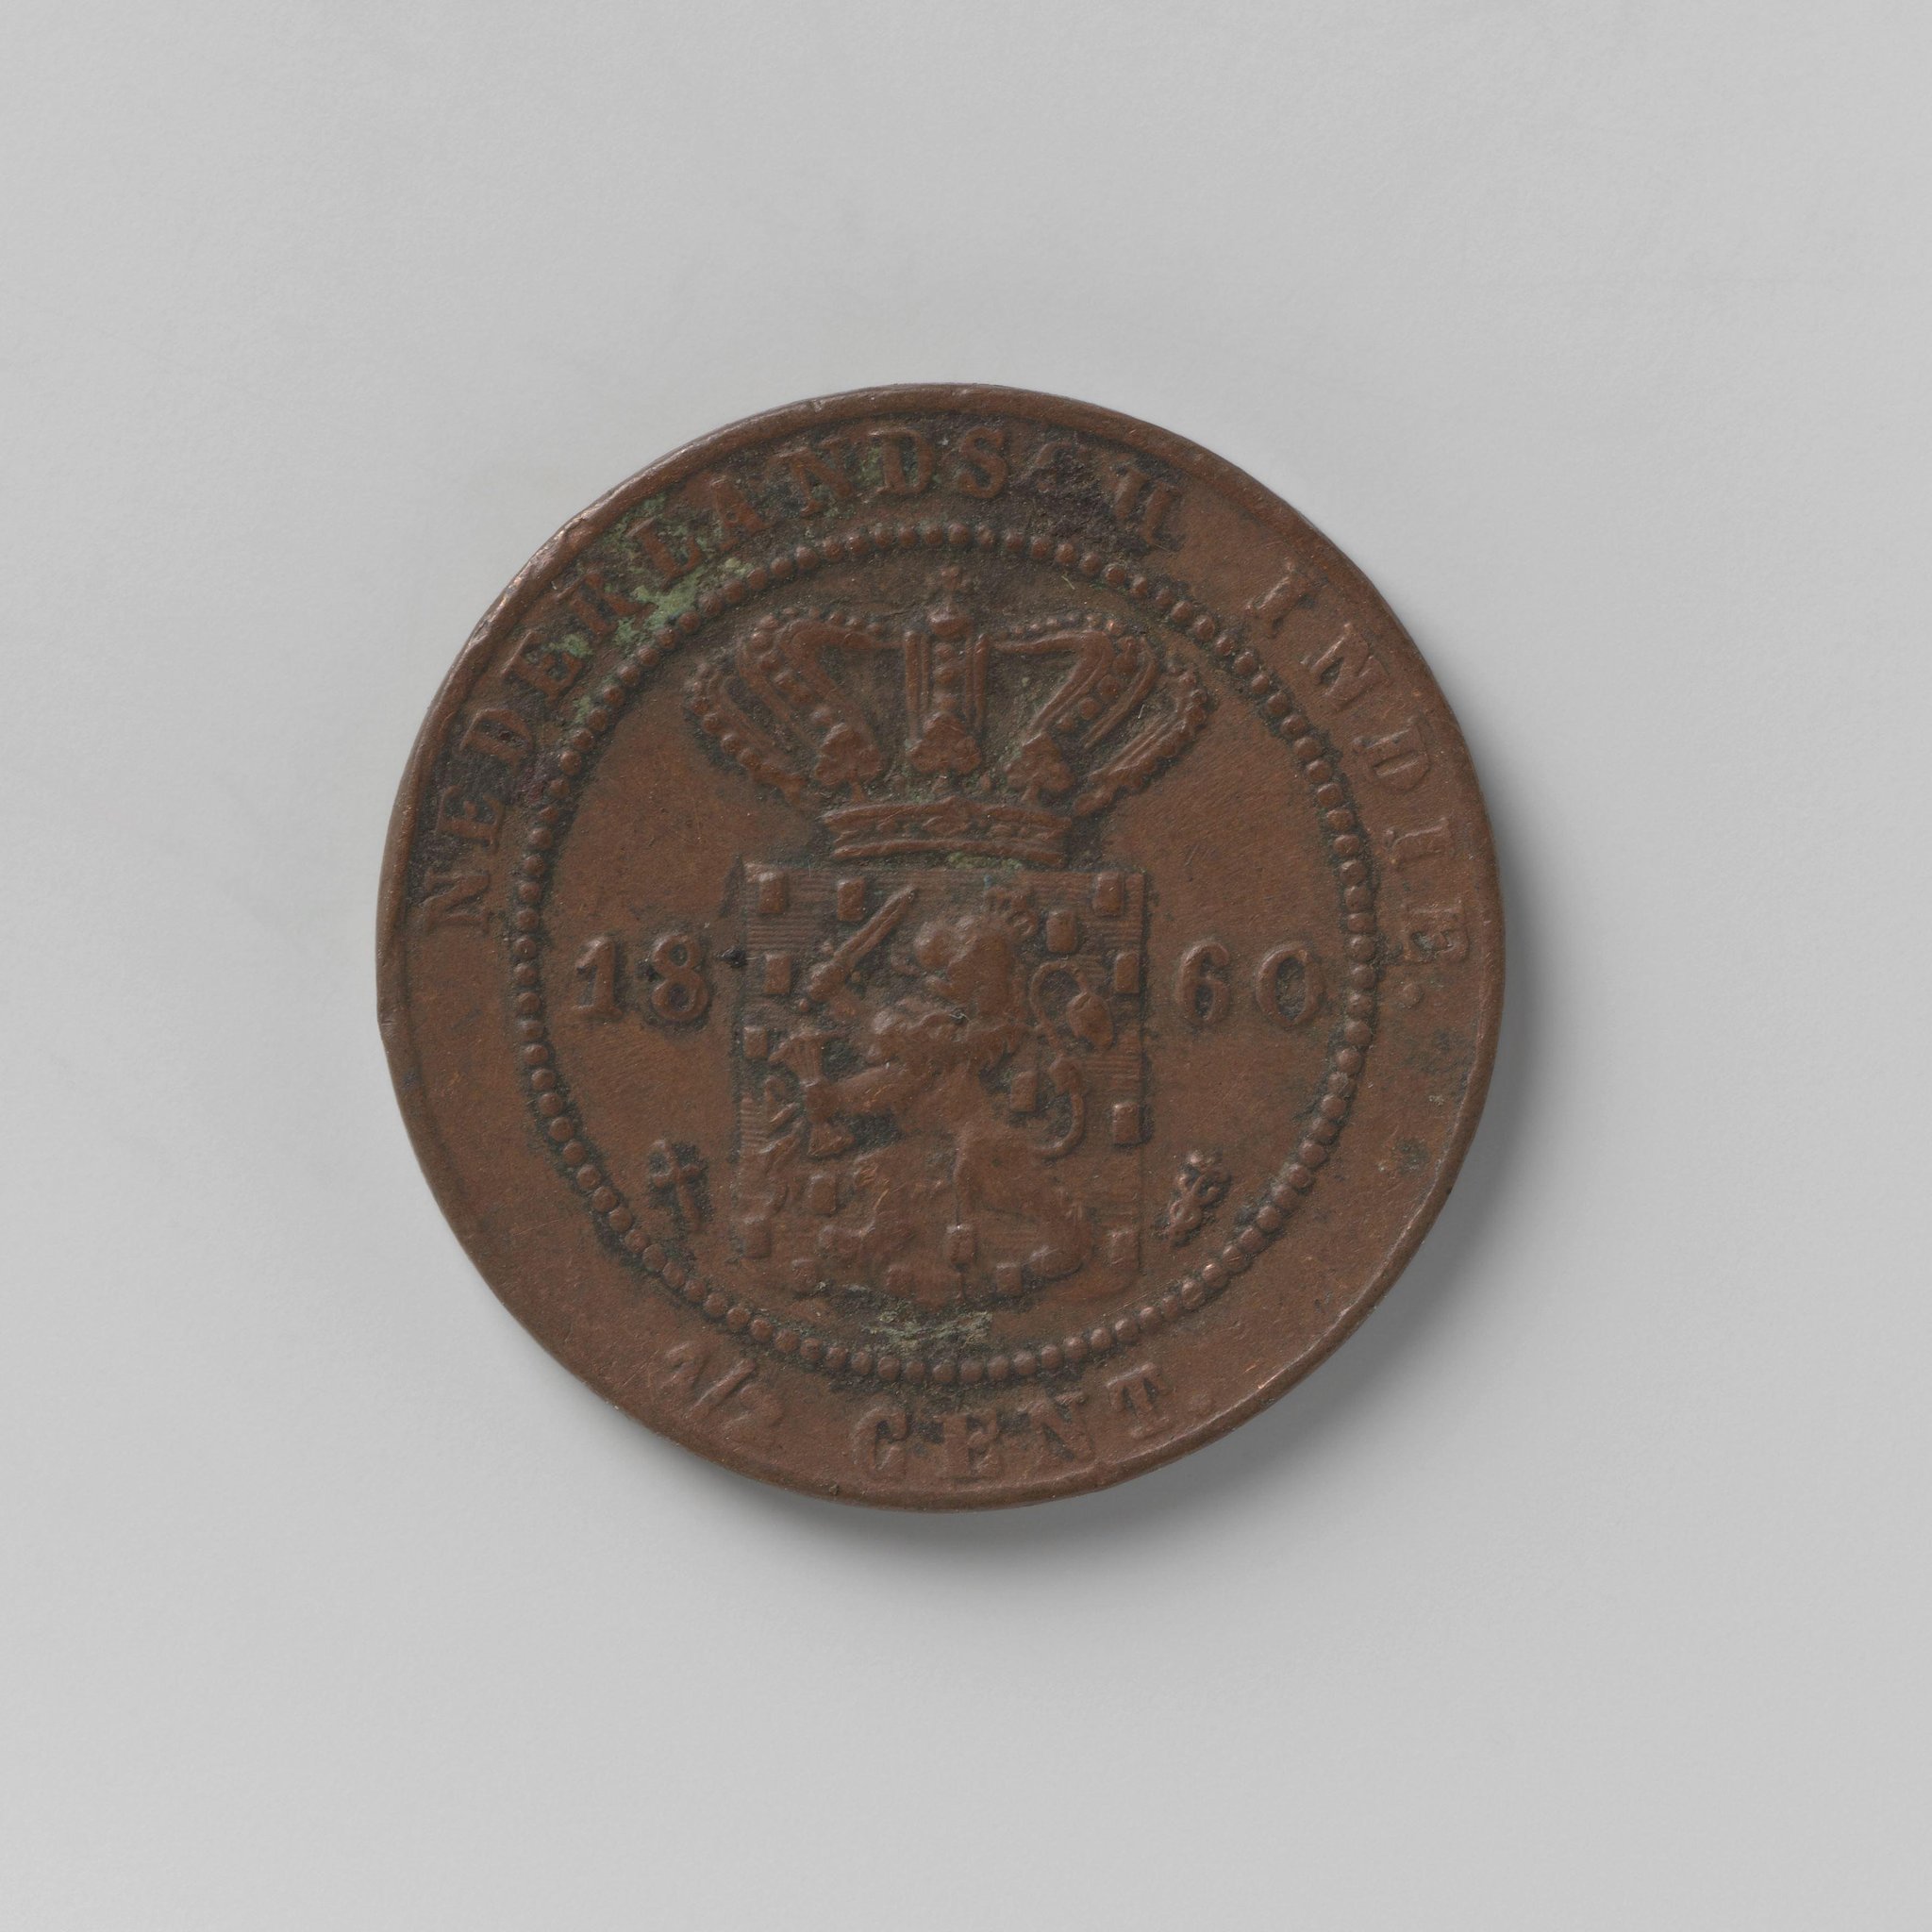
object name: coin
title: ½ cent van Nederlands Indië, 1860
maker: willem iii (koning der nederlanden)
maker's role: koning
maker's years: 1817-1890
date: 1860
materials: copper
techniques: striking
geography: utrecht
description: Koperen munt. Voorzijde: tussen jaartal gekroond rijkswapenschild. Boven kroon landsaanduiding en onder wapenschild waarde-aanduiding. Keerzijde: drieregelig Maleis opschrift in Arabische tekens, waaromheen omschrift in het Javaans. Gladde rand.